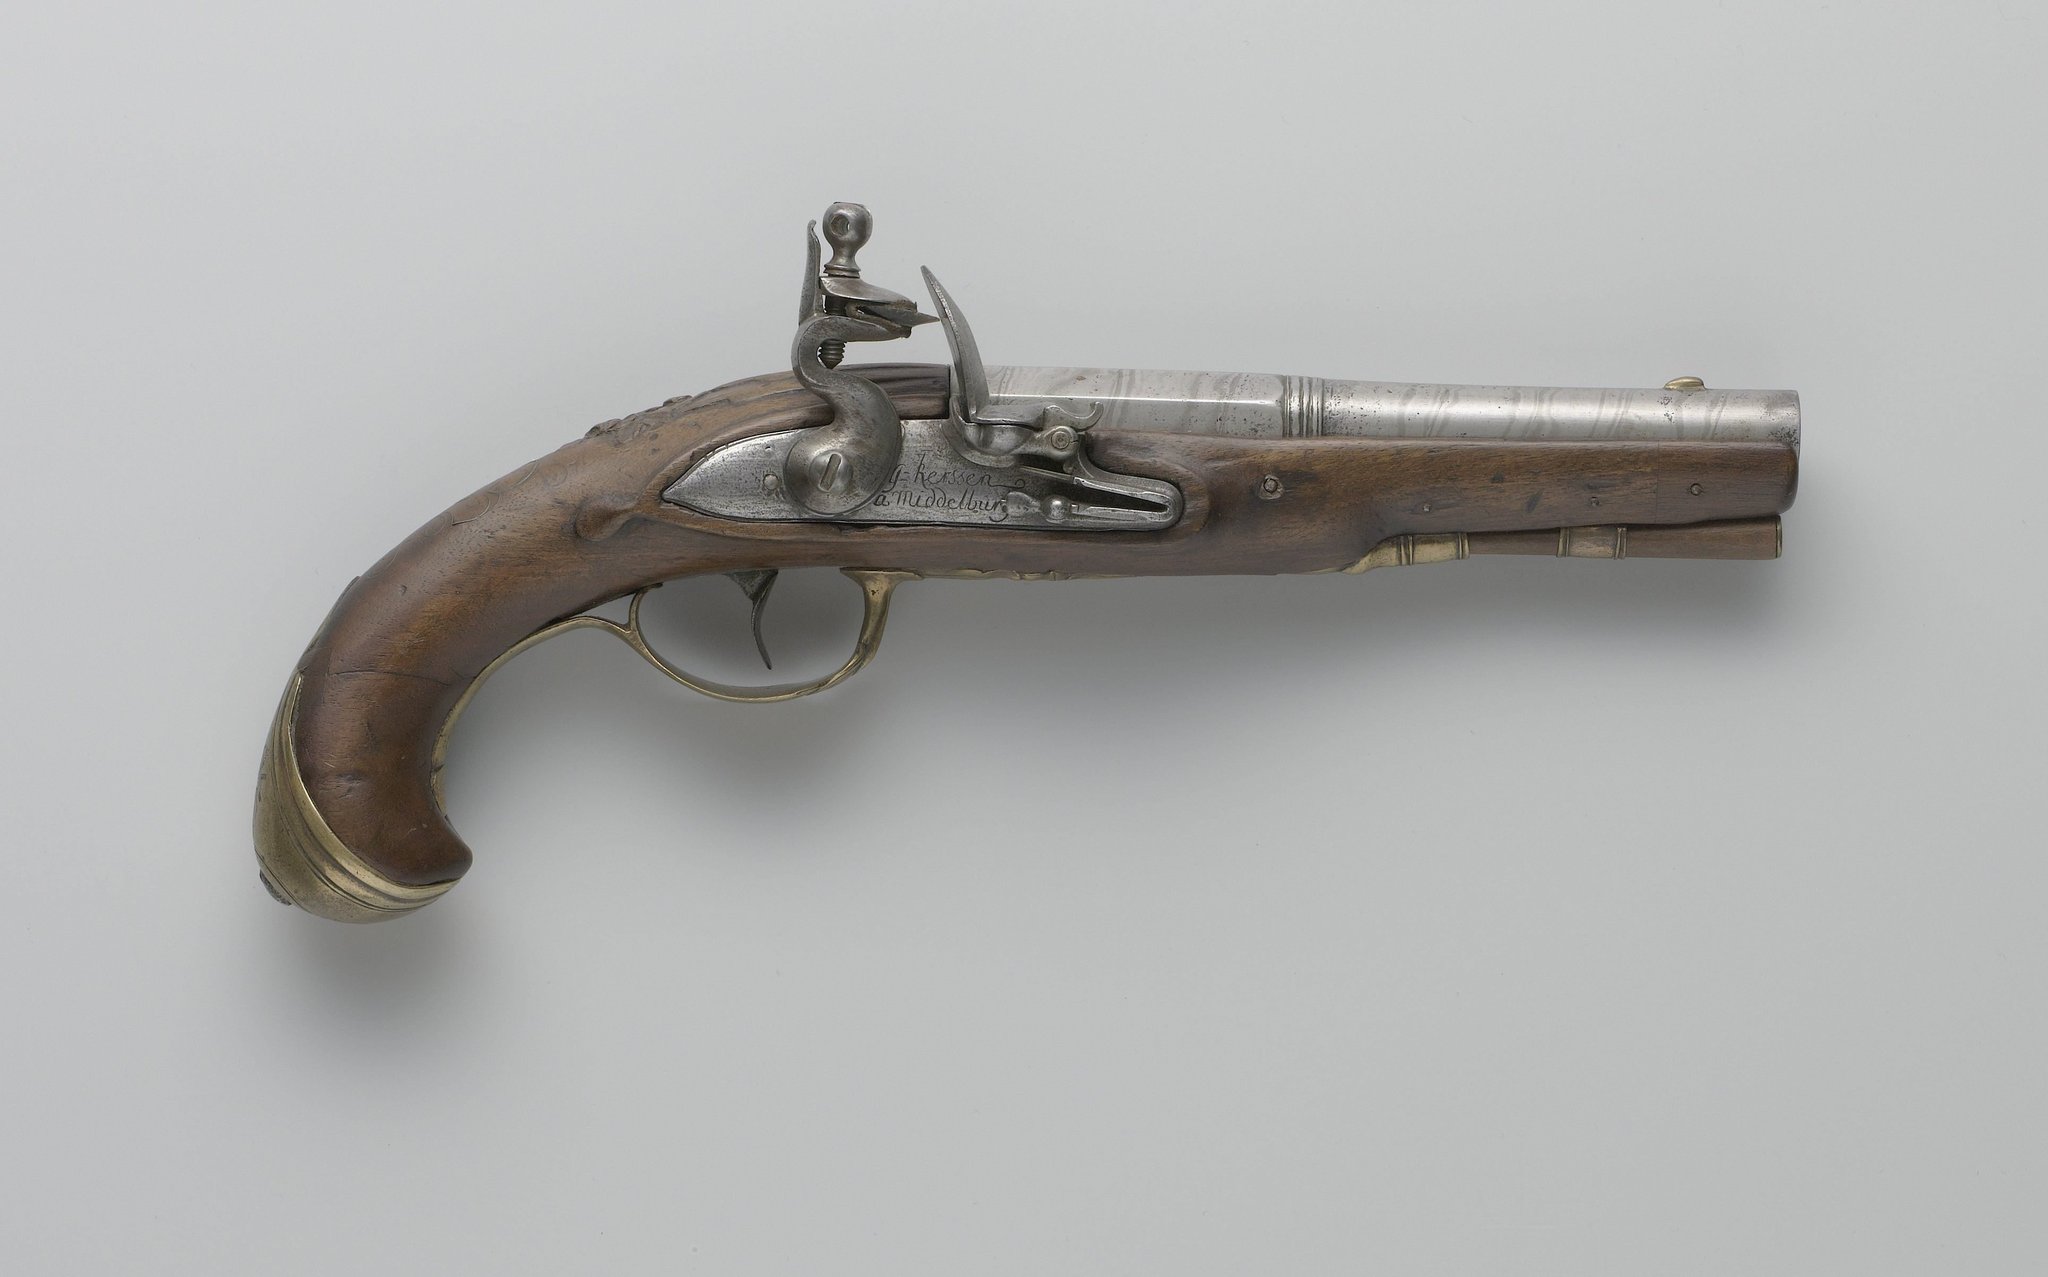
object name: flintlock pistol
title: Vuursteenpistool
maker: g. kerssen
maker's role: geweermaker, pistoolmaker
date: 1780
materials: brass, thread, steel, wood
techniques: printing, cutting, metalworking, engraving, gilding, inlay, striking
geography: middelburg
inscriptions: signature: ‘G=kerssen // a middelburg’, stamp: ‘FS’, coat of arms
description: Het slot is onversierd op een signatuur en een stempel op de slotplaat na. De loop van gedamasceerd staal is grijs en heeft een geelkoperen korrel; bovenop staat een stempel met het wapen van Middelburg. De kolf is in reliëf gesneden met een bos rozen en ingelegd met zilverdraad rond een cartouche op de greep. Het beslag is gemaakt van verguld geelkoper en bestaat onder meer uit een kolfkap die gegraveerd is met randen, ranken met bladeren en een krijgstrofee.